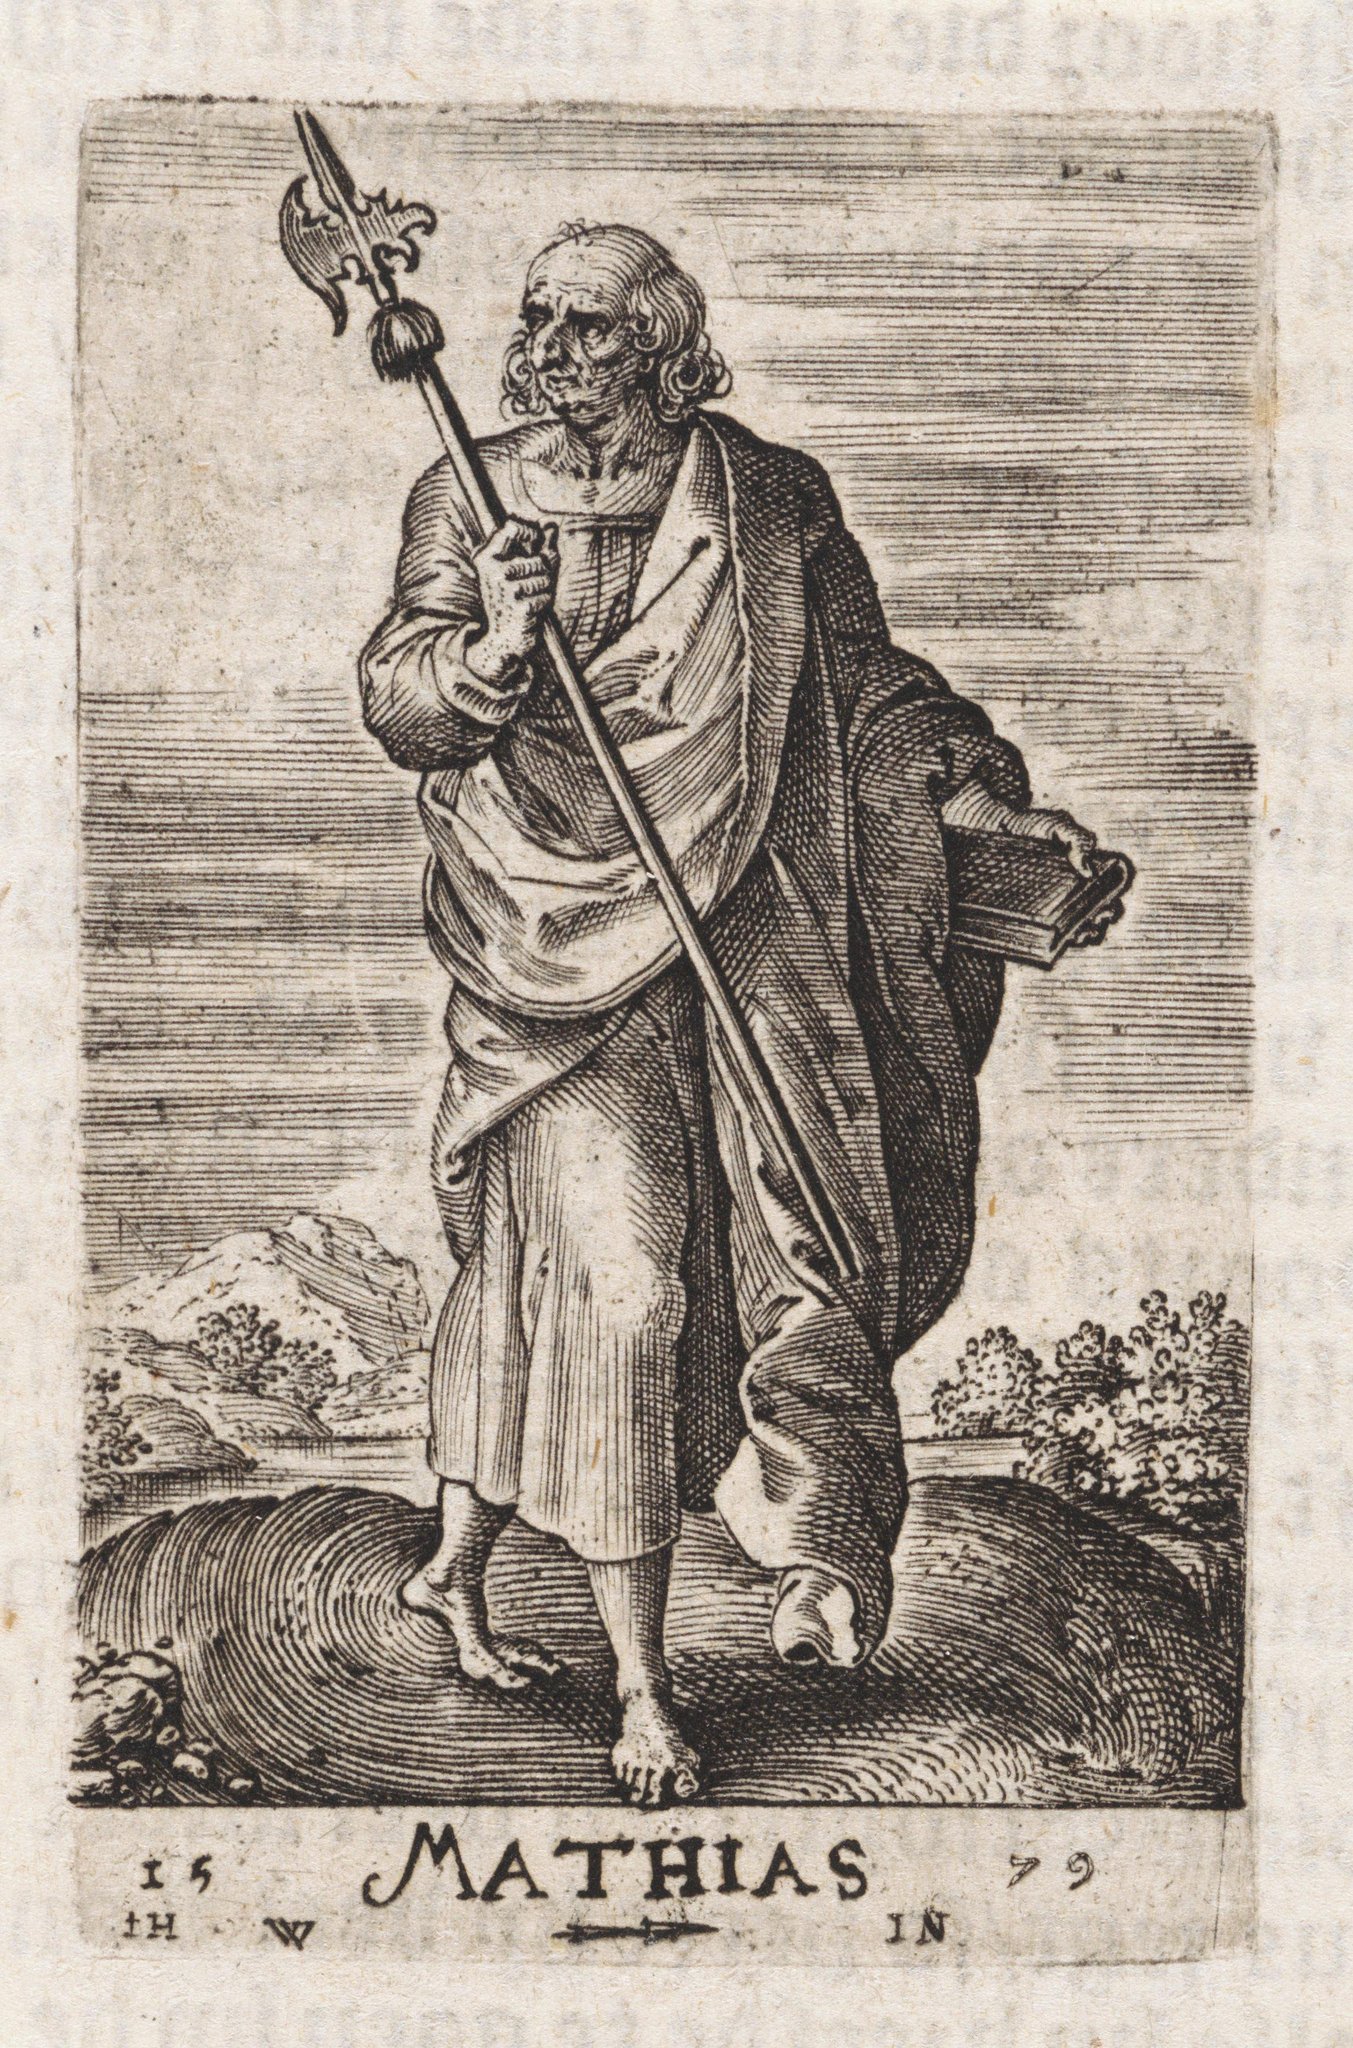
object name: print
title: Christus en de twaalf apostelen, en H. Paulus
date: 1579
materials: paper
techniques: engraving, letterpress printing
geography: delft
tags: the apostle and martyr matthias; possible attributes: axe, book, cross, halberd, scroll, sword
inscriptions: collector's mark: Lugt 2228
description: Prent gebruikt als illustratie in: Const-toonneel, inhoudende de beschrijvinghe ende XL. Heerlijcke afbeeldindinghen: Onses Heeren Jesu Christi, met sijne apostelen, ende evangelisten, midtsgaders de hooft-deuchden ende ondeuchden. Ende ten laetsten de seven planeten. In coper gesneden door Johannis Wierix. De beschrijvinge is (...). Delft: Nicolaes de Clerck, 1609.